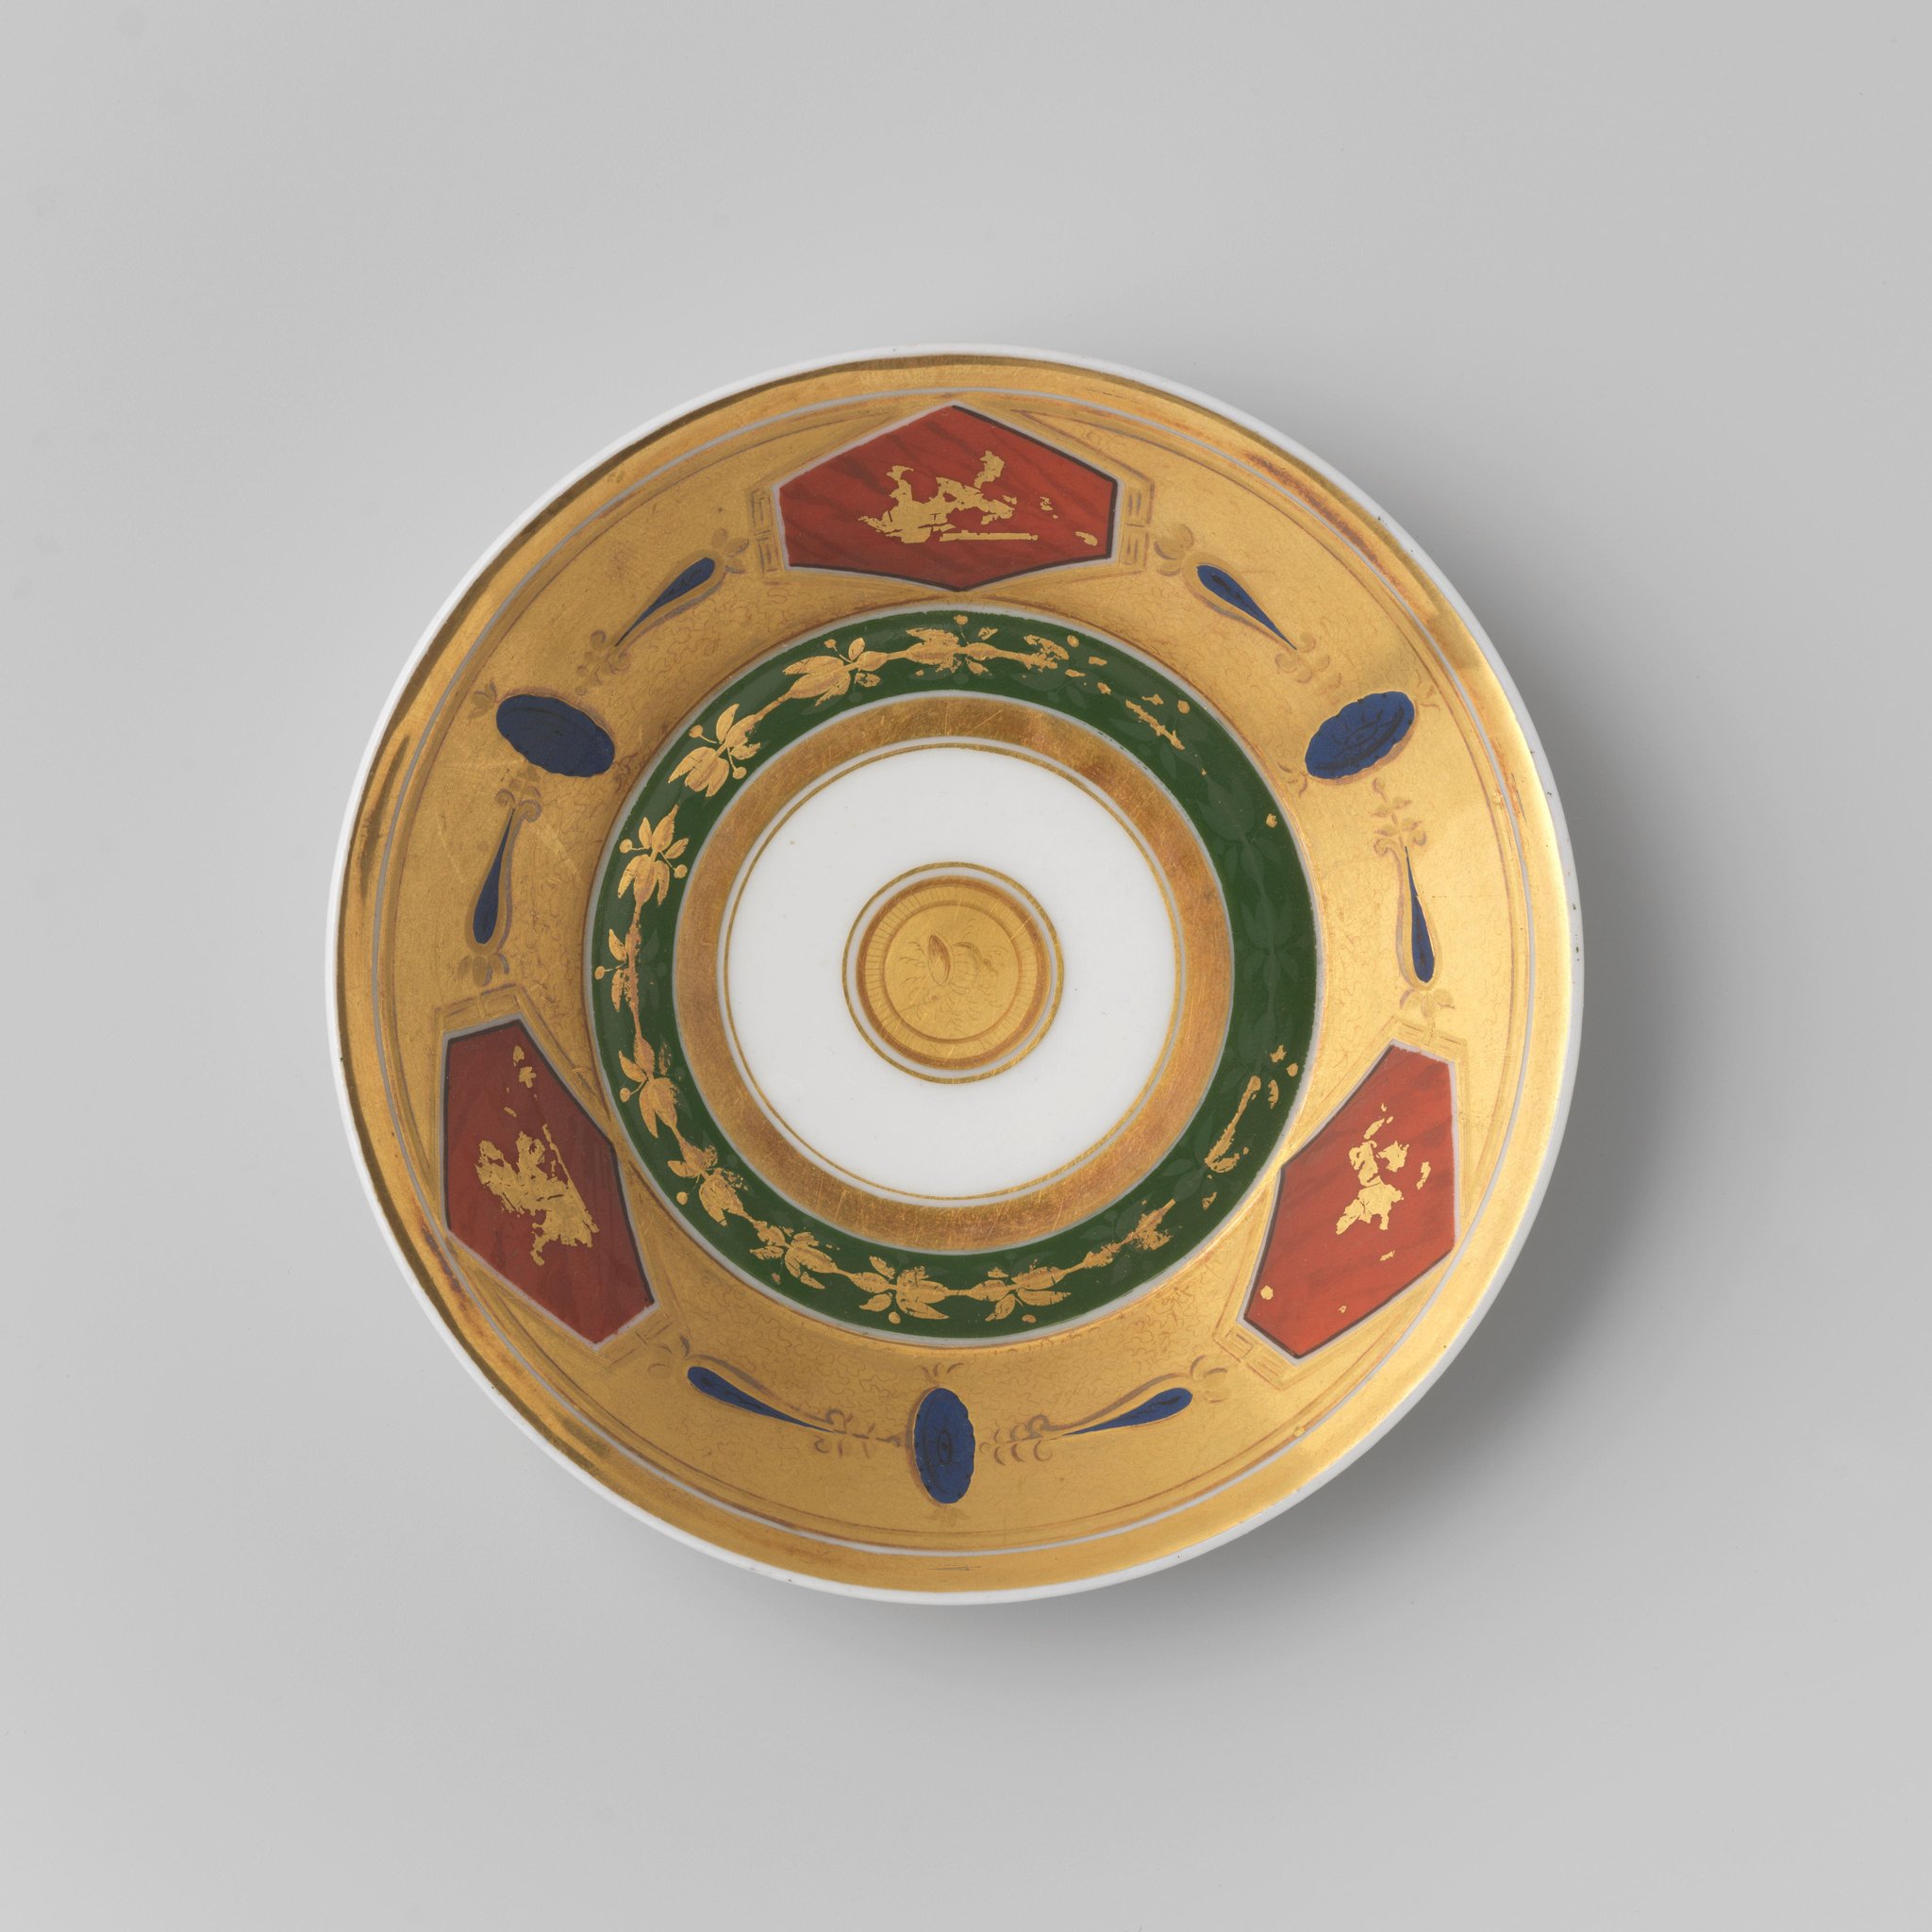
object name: platter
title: Saucer with griffins and floral scrolls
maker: Anonymous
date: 1800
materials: glaze, gold, paint, porcelain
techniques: firing, forming, gilding, relief, turning, vitrification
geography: france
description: Schotel van porselein met rechte wand, beschilderd op het glazuur in blauw, rood, groen, zwart en goud. Op het plat een gouden medaillon met daarin gegrift een pot en takken. Hieromheen een gouden band en een band met bloemranken. De wand is bedekt met goud met daarop driemaal een zeshoekig vak met een griffioen[?]. De vakken zijn aaneengeschakeld met blauwe bloemvormen. Gouden rand.